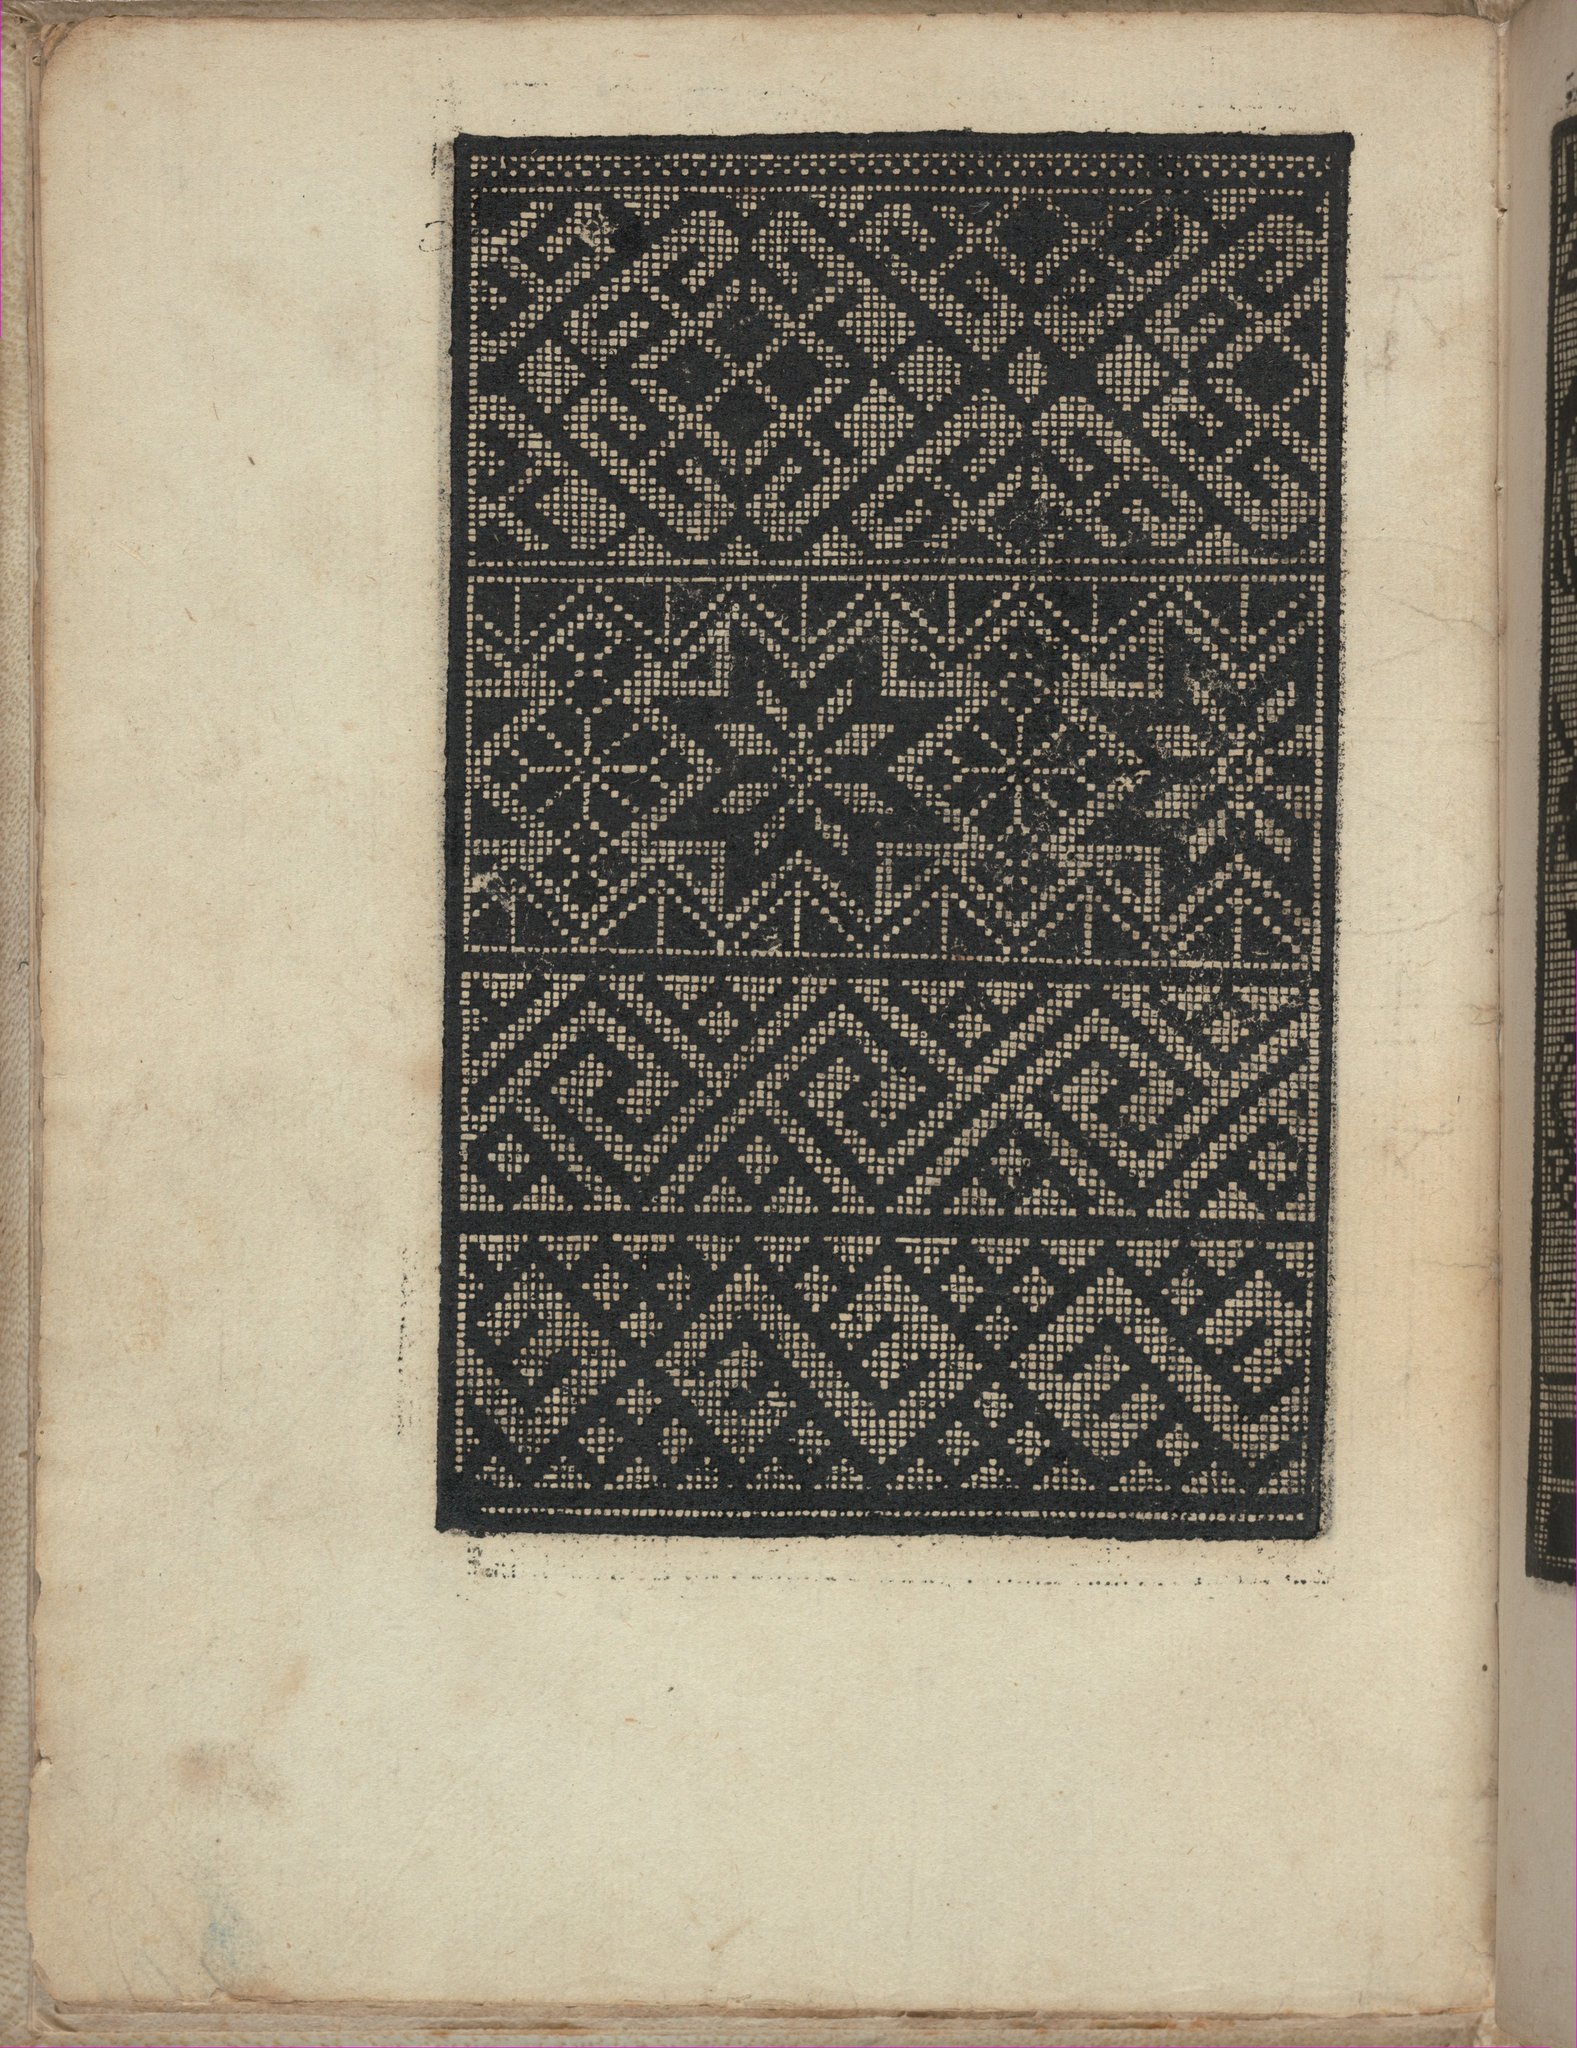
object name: book print ornament architecture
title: Esemplario di Lauori..., page 12 (recto)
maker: giovanni andrea vavassore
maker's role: publisher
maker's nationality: italian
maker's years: 1530-1573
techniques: woodcut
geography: venice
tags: men,flowers